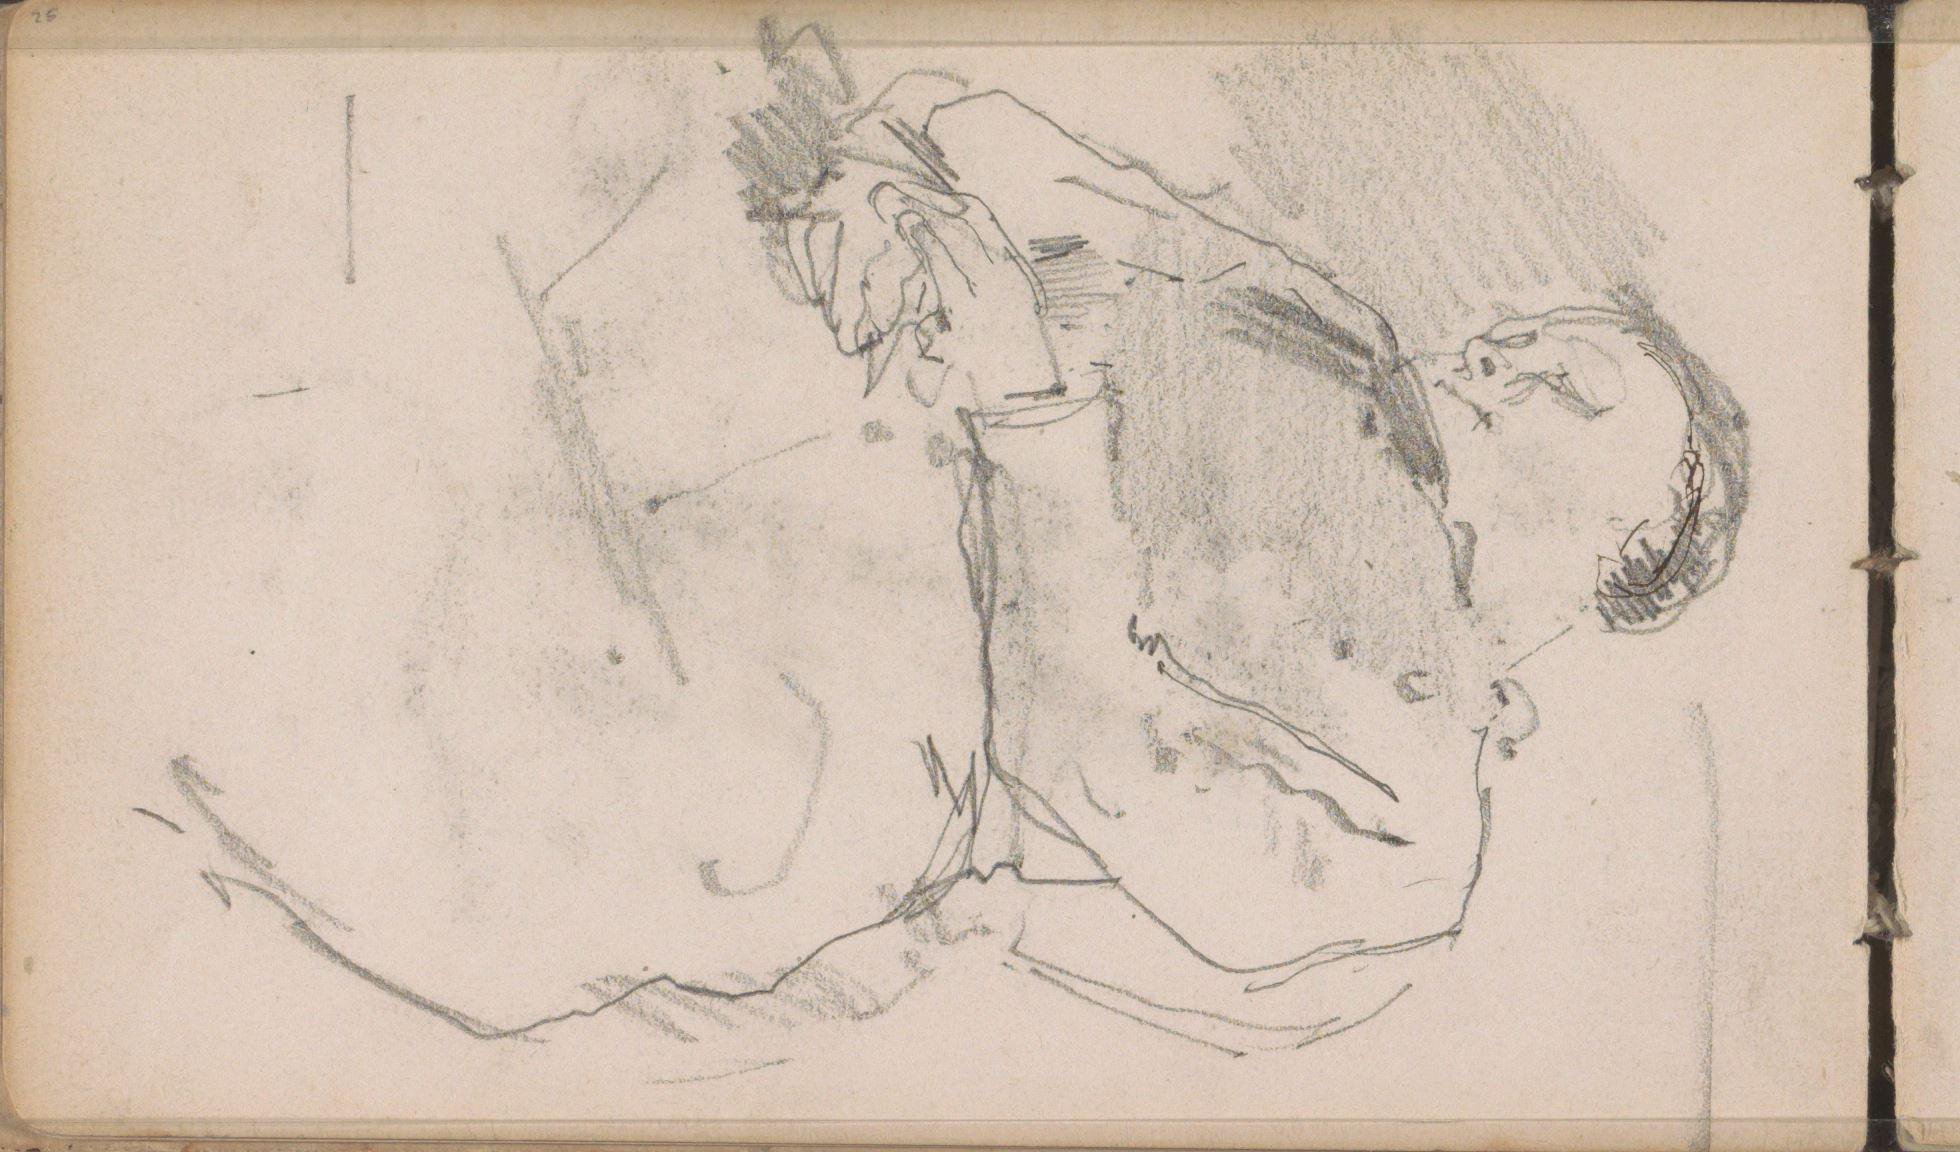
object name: sketchbook leaf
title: Figuur met de handen op elkaar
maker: george hendrik breitner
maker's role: draughtsman, painter, print maker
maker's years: 1857-1923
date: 1881-1883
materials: ink, paper, pencil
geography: north brabant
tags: adult woman, adult man, hands on top of each other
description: Pagina 25 uit een schetsboek met 42 bladen.